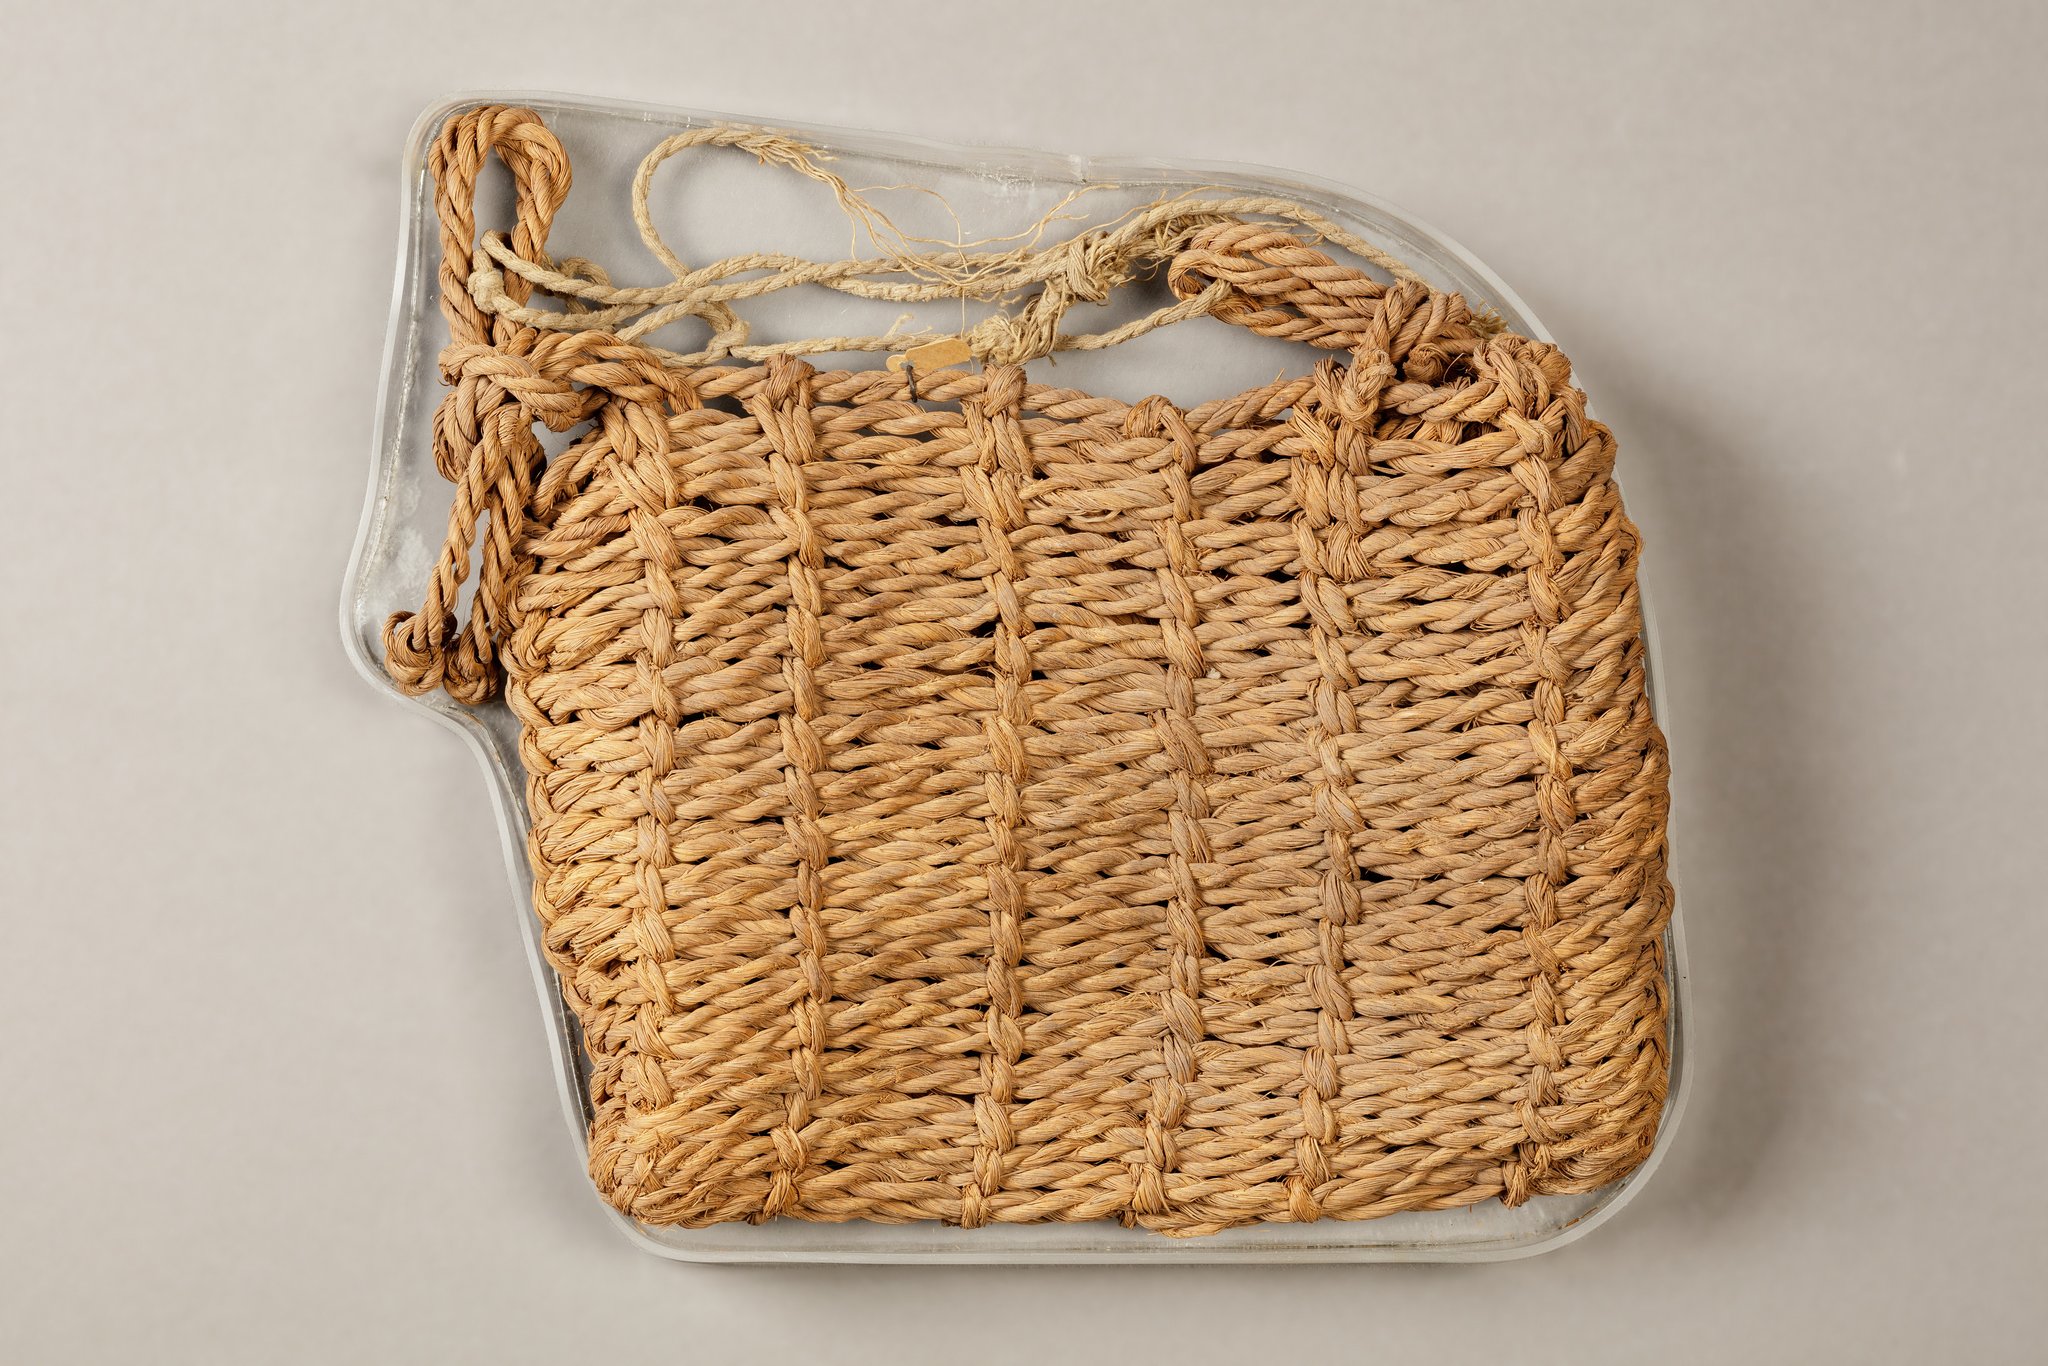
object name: model donkey bag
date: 2030-1640 BCE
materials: fiber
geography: egypt